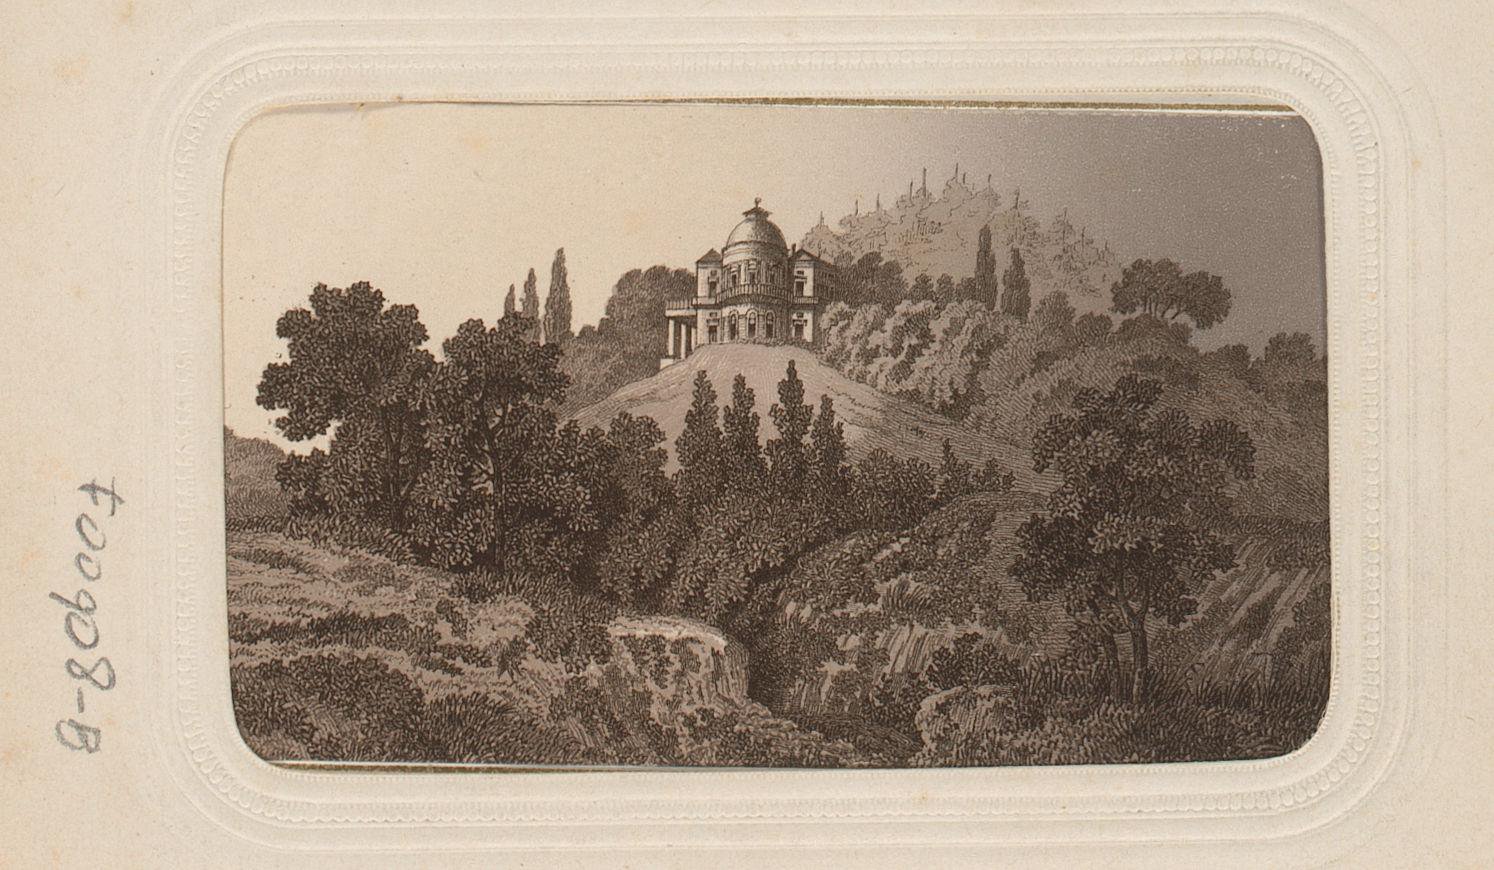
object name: album leaf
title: Fotoreproductie van prent van een gezicht op de Louisberg bij Aken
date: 1860-1885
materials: cardboard, photographic support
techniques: collodion silver print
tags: city-view, and landscape with man-made constructions, (high) hill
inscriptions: annotation: ‘Louisberg bij Aken’, annotation: ‘Louisberg/ bij Aken’